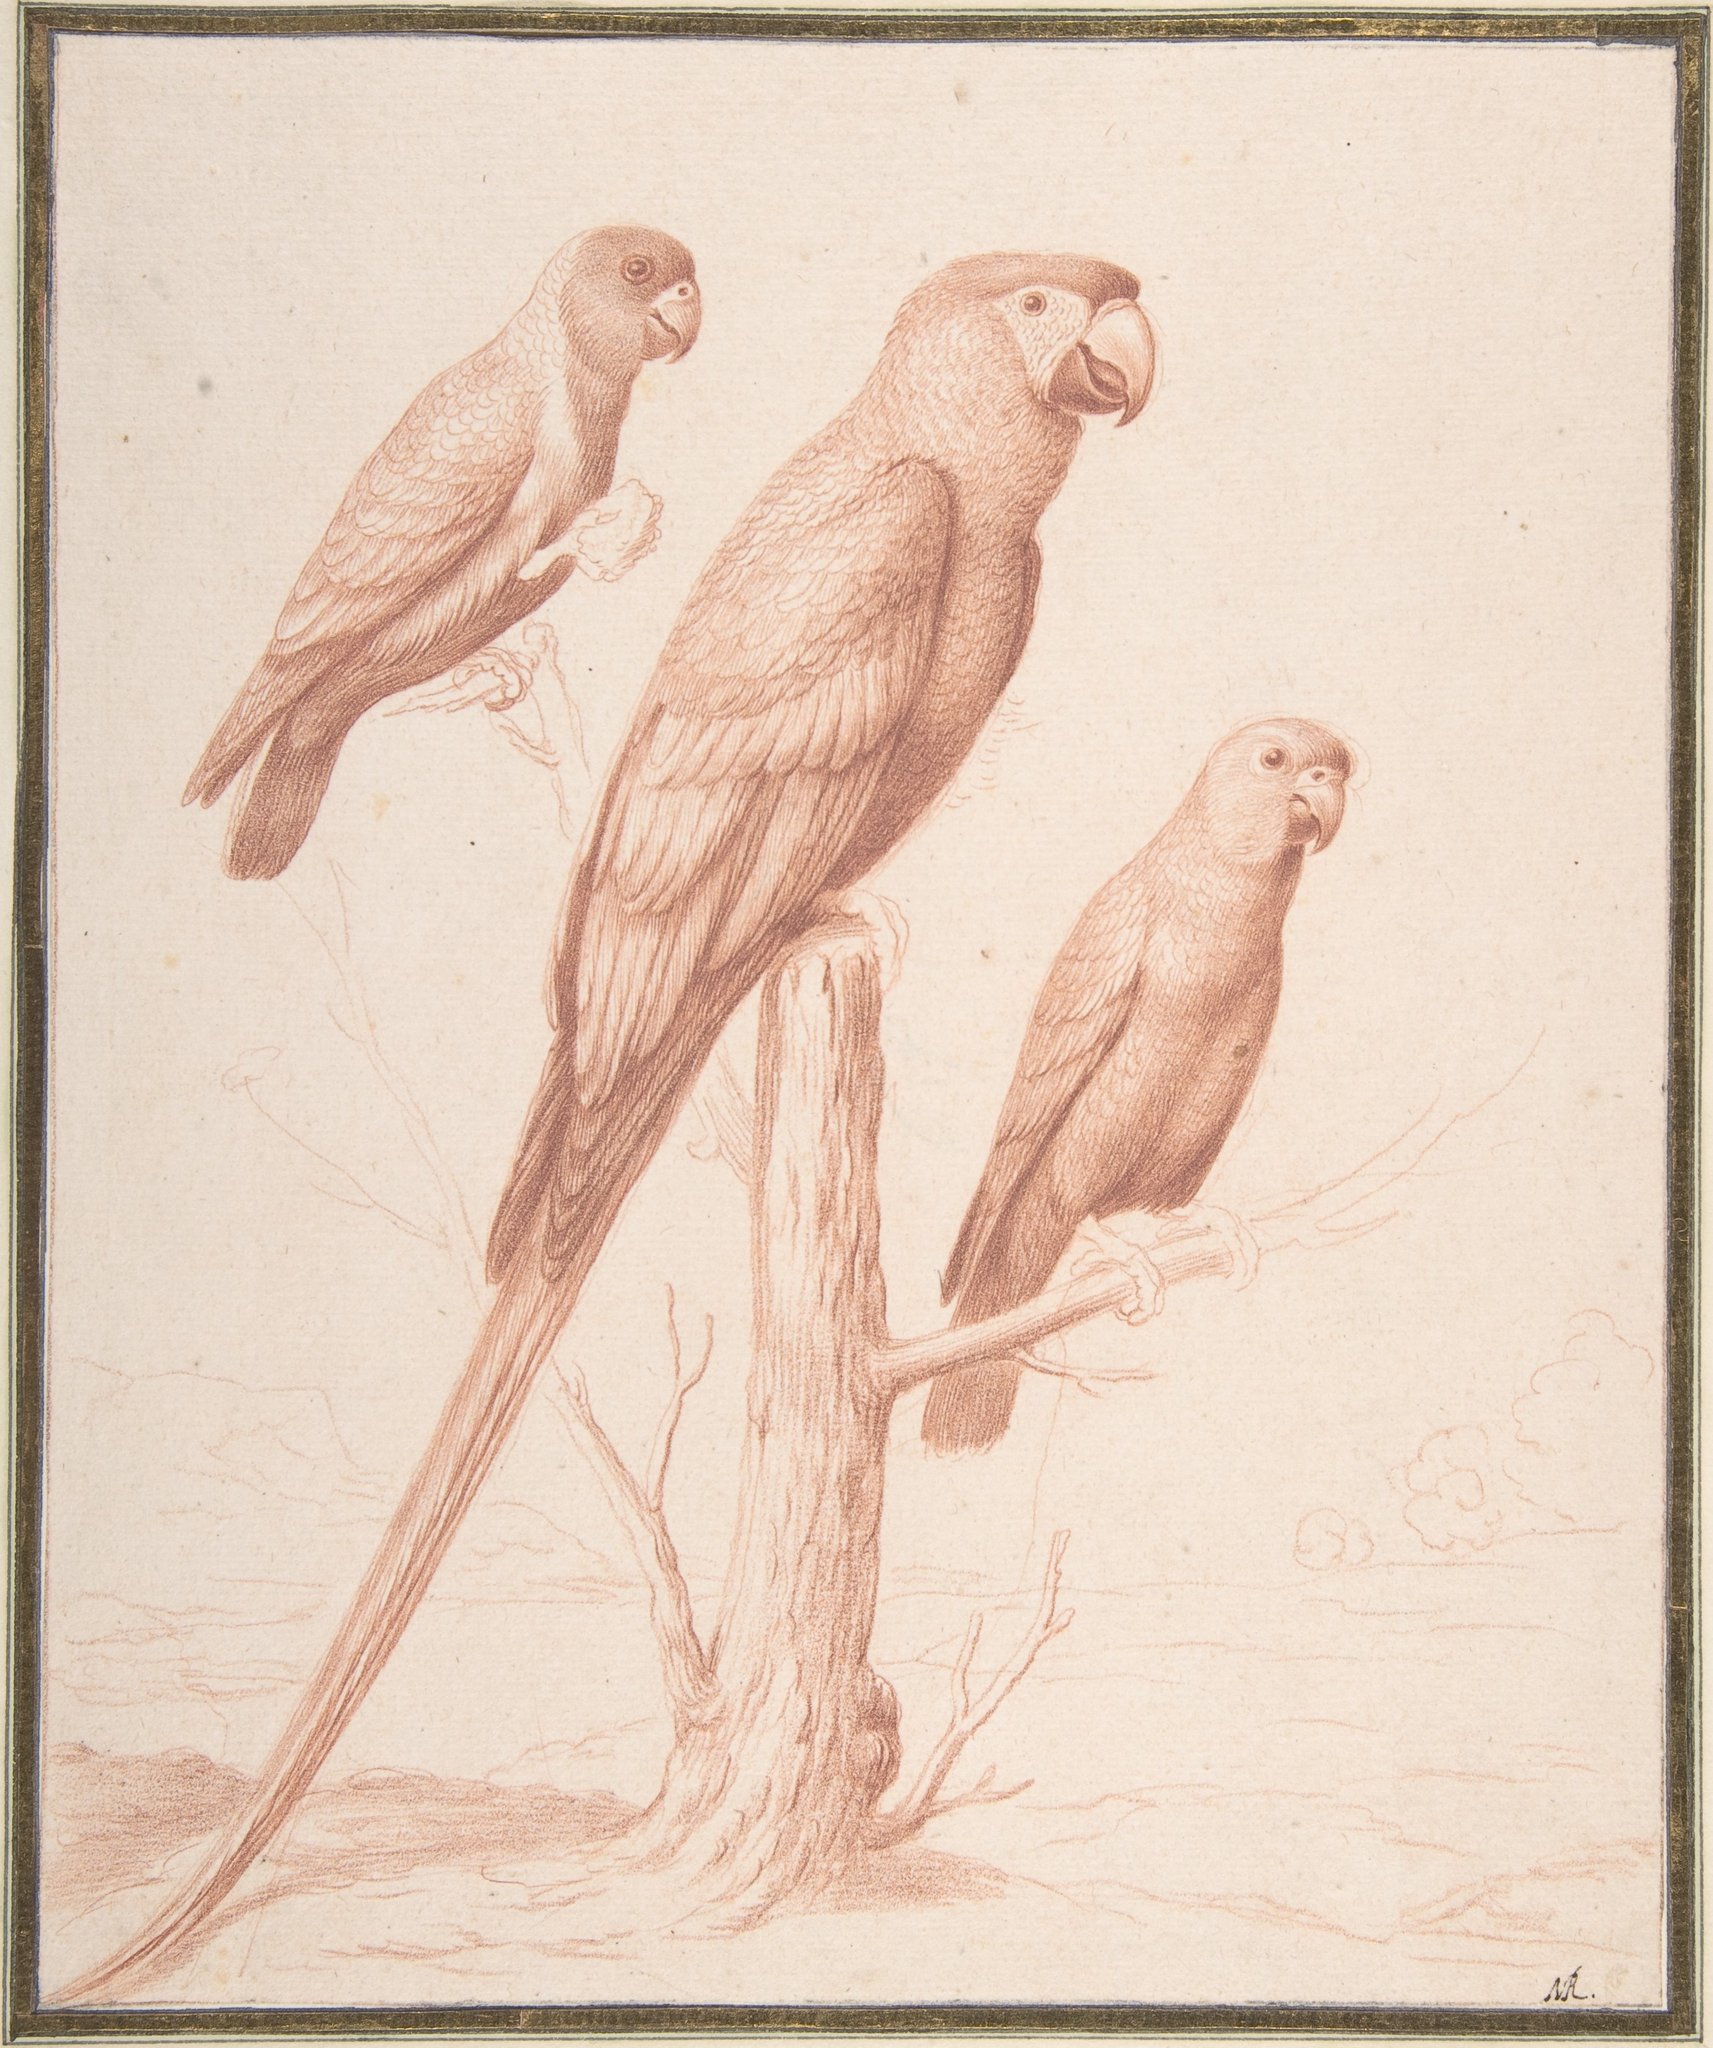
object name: drawing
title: Three Parrots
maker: nicolas robert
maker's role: artist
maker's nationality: french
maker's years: 1614-1685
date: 1675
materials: chalk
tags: parrots